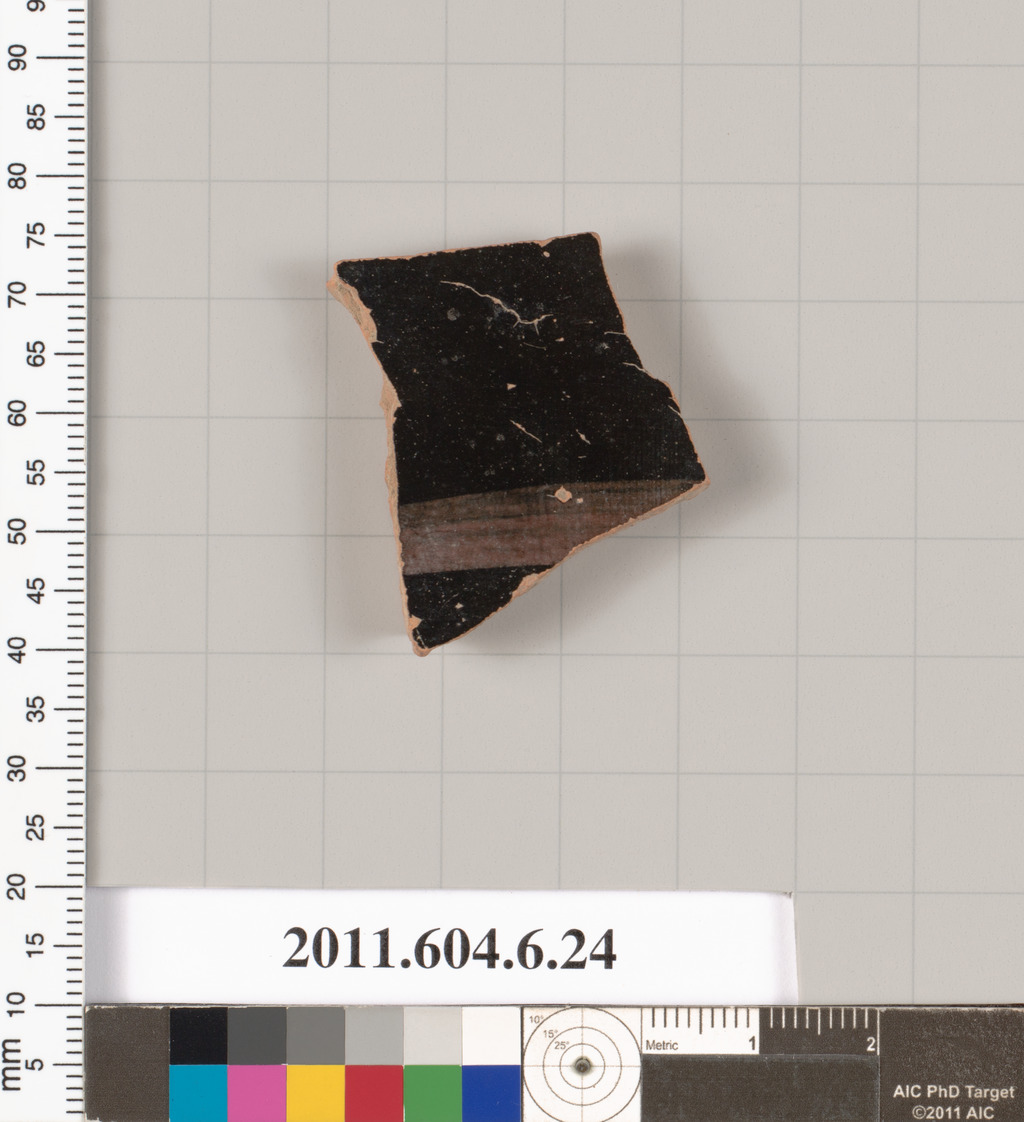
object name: undetermined closed shape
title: Terracotta fragment of a closed shape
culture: greek, attic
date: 600-401 BCE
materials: terracotta